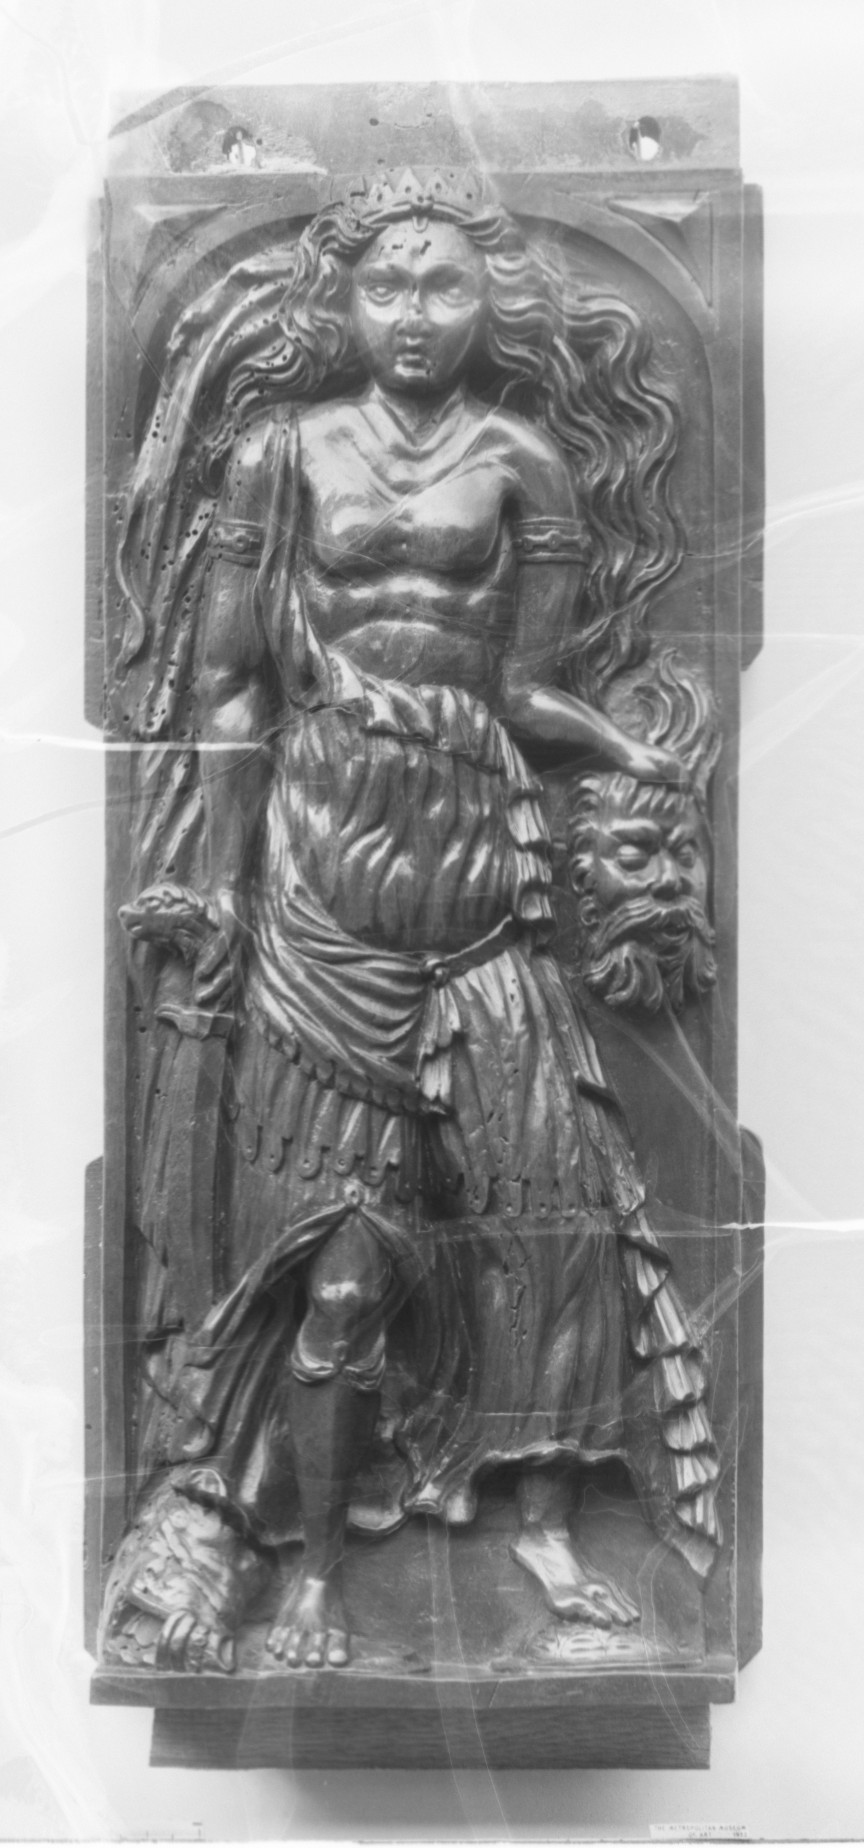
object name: panel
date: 1501-1600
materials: wood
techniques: carving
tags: heads,men,women